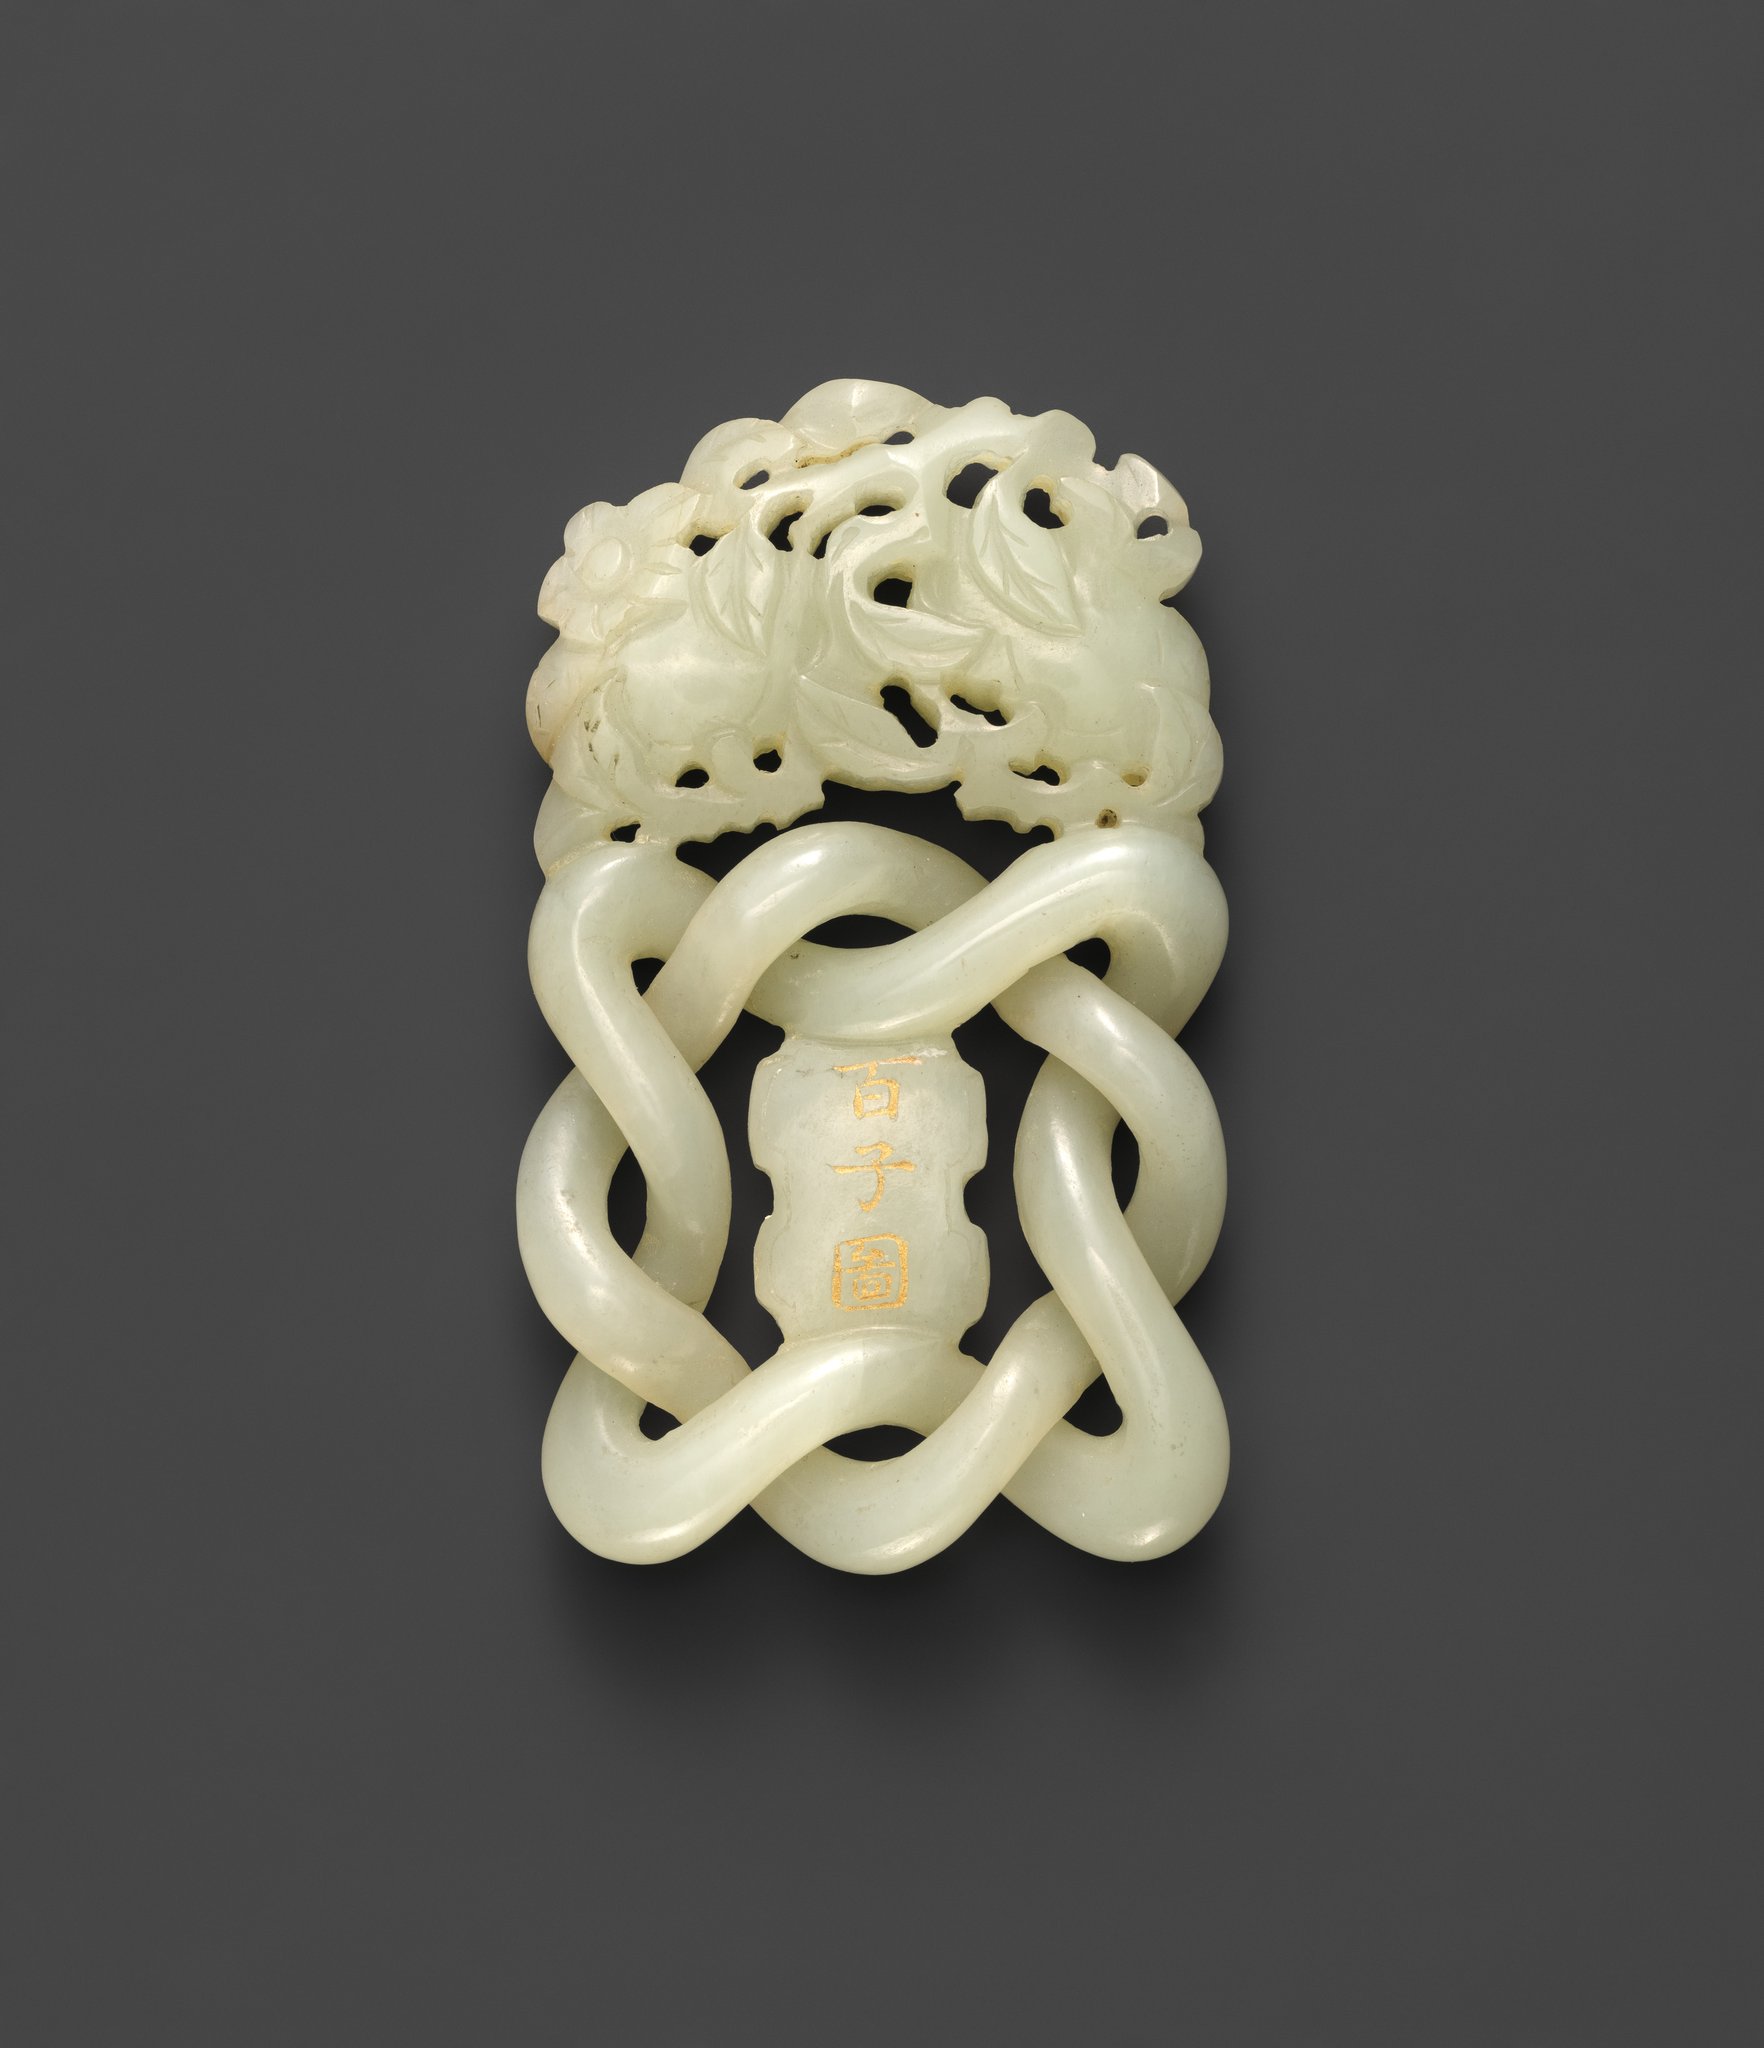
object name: ornament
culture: chinese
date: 1701-1900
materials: jade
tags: flowers,leaves